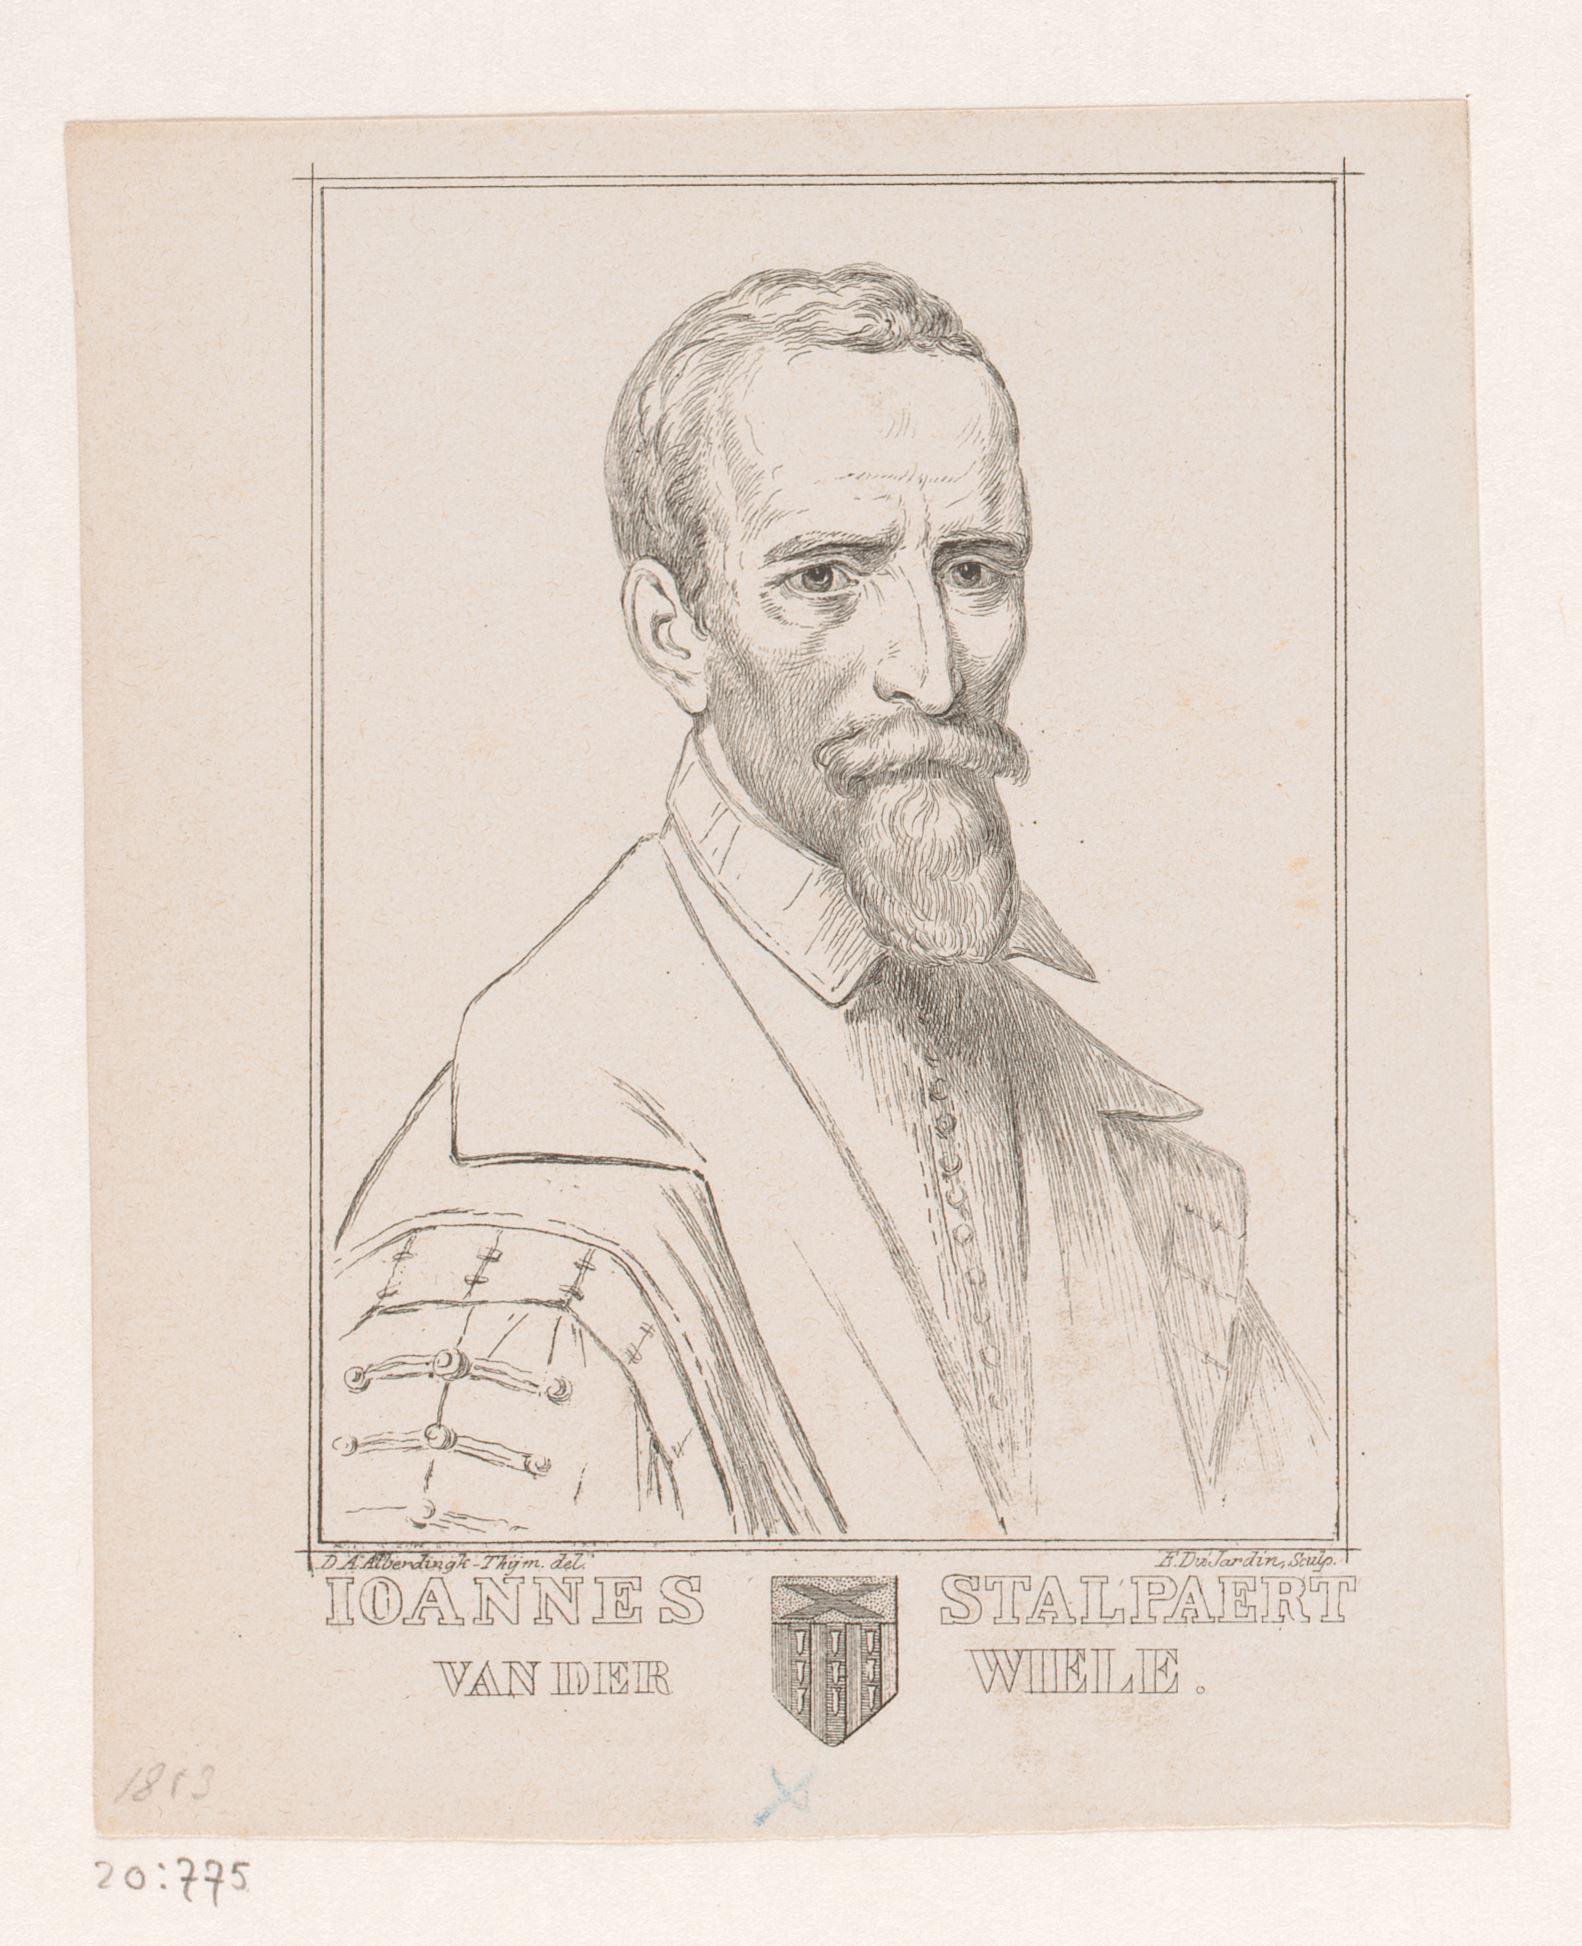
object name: print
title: Ioannes Stalpaert van der Wiele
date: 1852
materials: paper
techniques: lithograph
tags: adult man, historical persons, beard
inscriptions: collector's mark: Lugt 2228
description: Prent gebruikt in: Alberdingk Thijm, Josephus Albertus. Joannes Stalpaert van de Wiele. S.l.s.n., 1852.